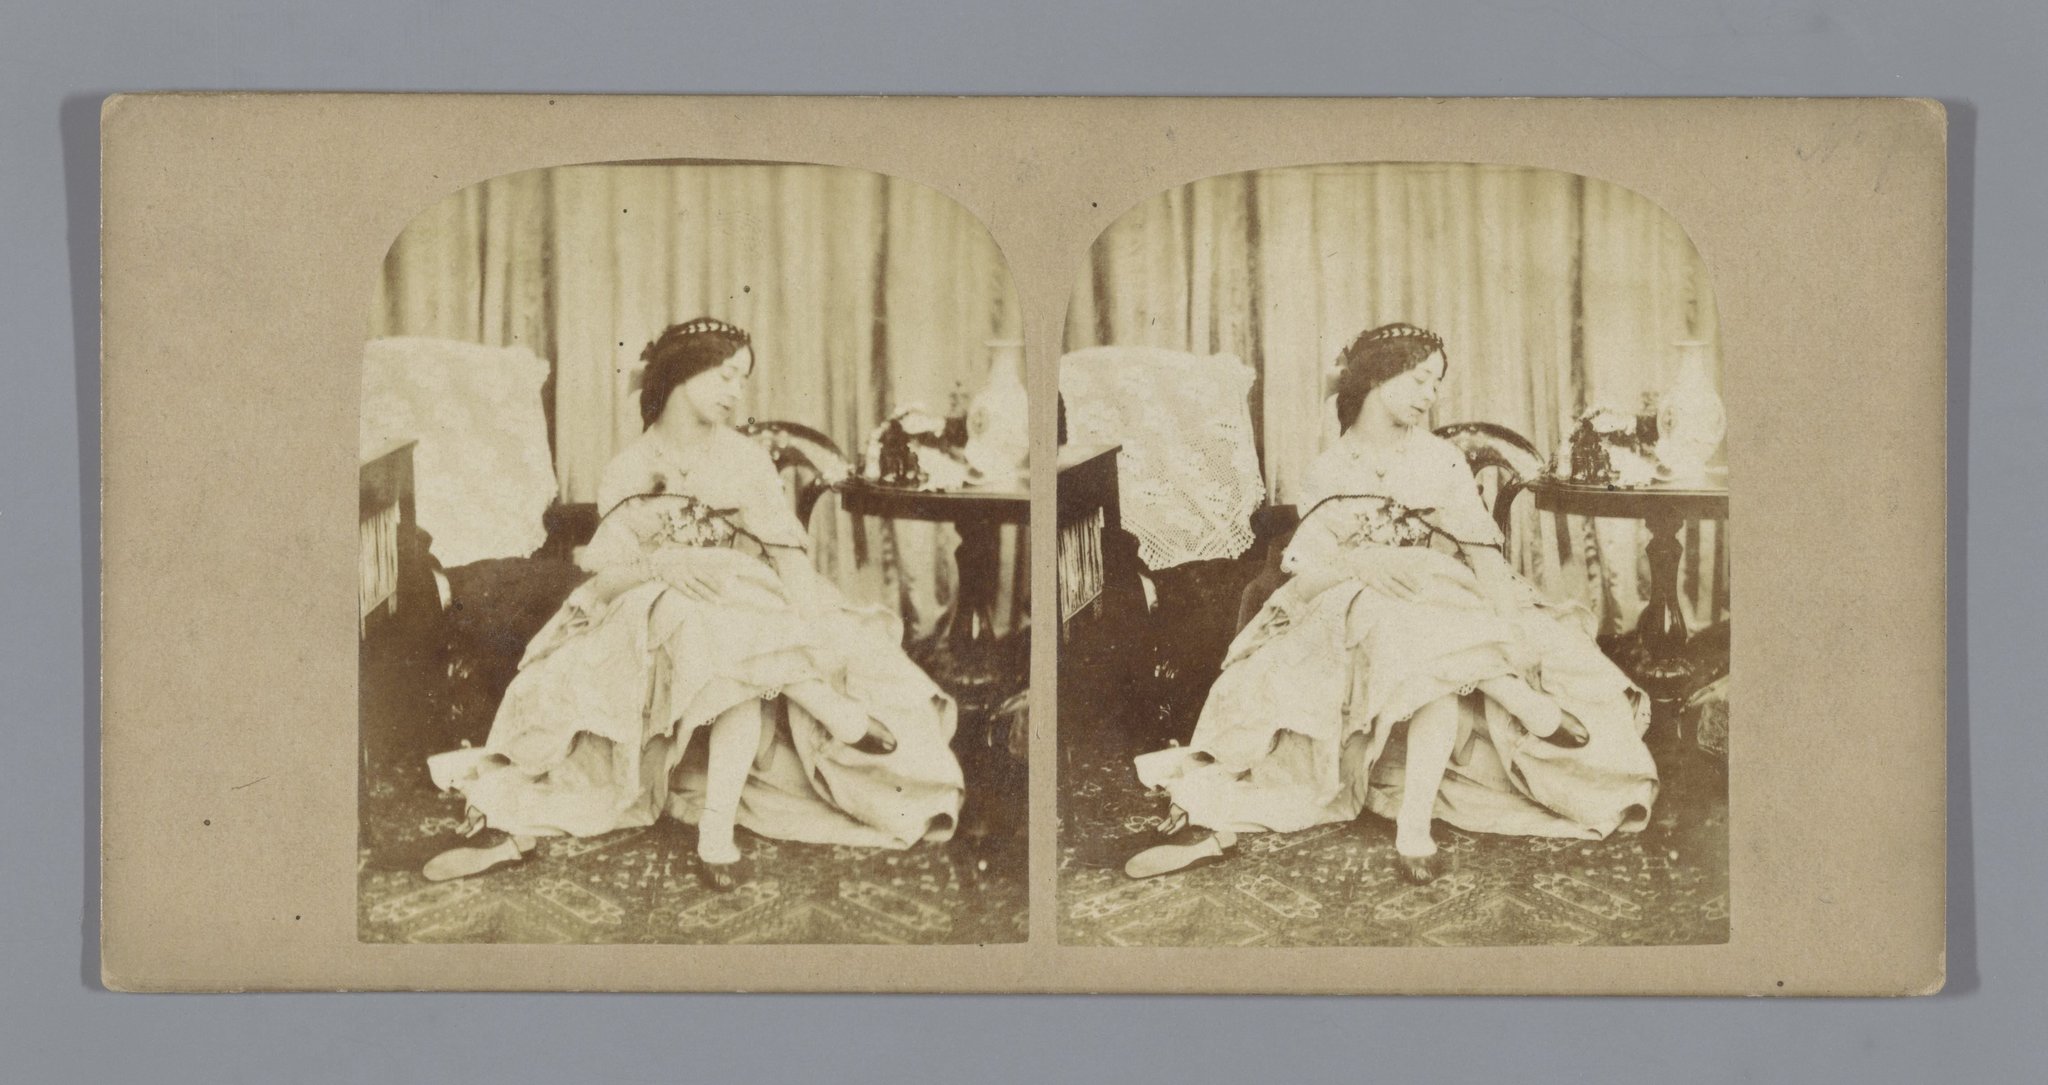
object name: stereograph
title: Portret van een onbekende, zittende vrouw die haar voet vasthoudt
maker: Anonymous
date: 1850-1880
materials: cardboard, photographic support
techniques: albumen print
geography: europe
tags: sitting figure, europe